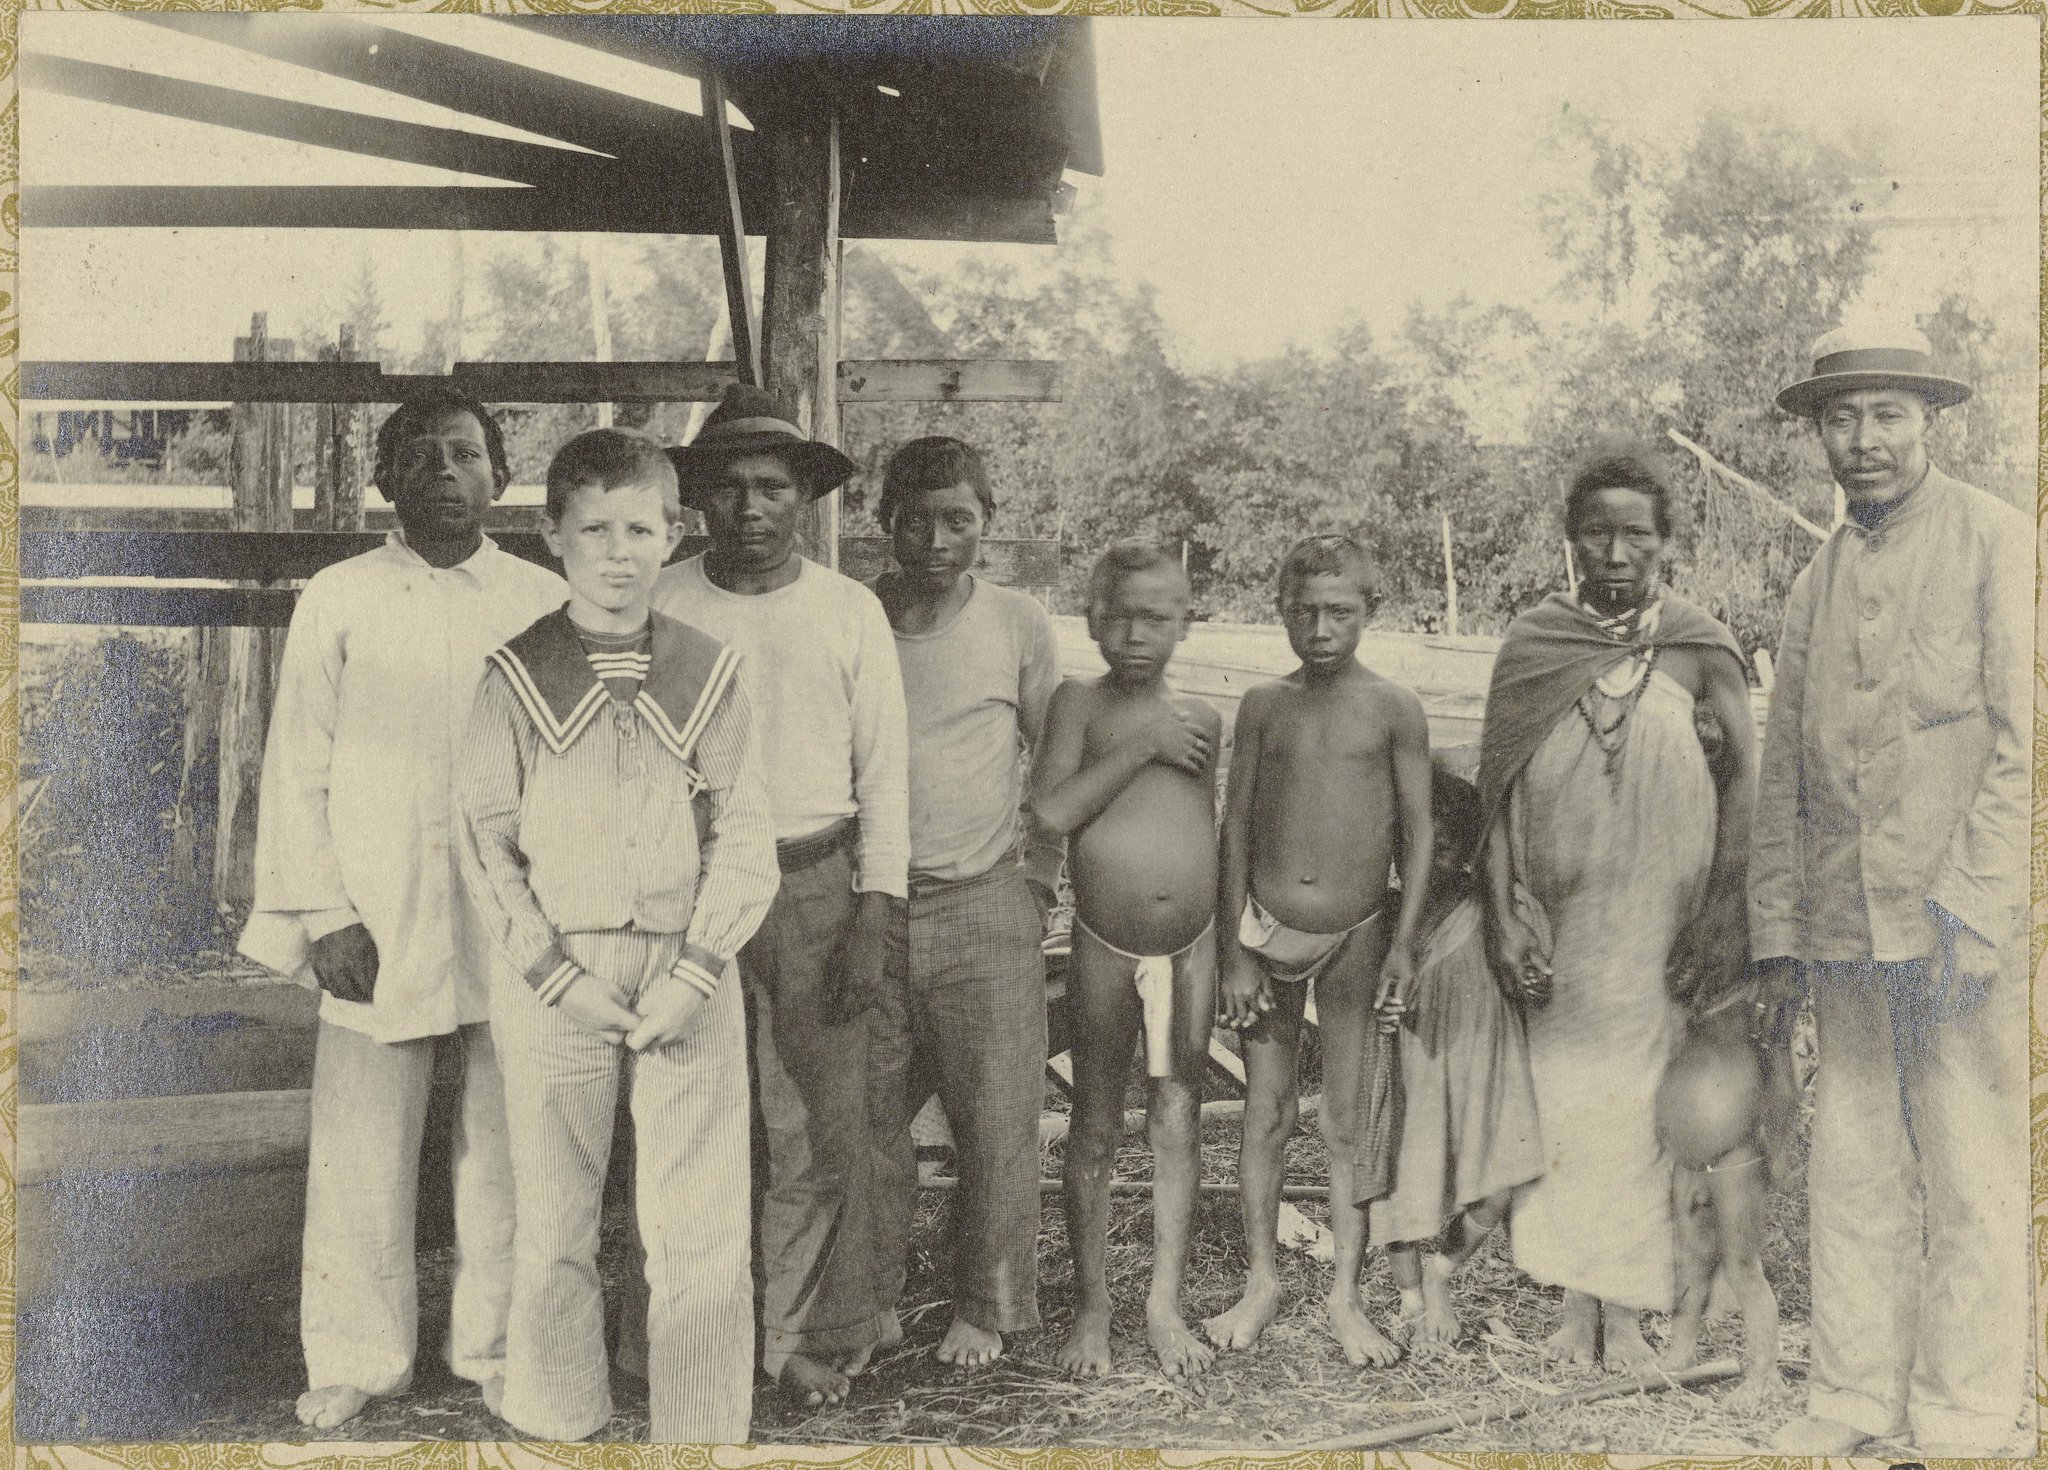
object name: photograph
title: Anton met Arowakken en Marrons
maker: hendrik doijer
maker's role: engineer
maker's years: 1863-1925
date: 1903-1910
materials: photographic support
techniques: gelatin silver print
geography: suriname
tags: suriname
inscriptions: inscription: ‘B2’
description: De Nederlandse jongen Anton staand poserend voor een groep Surinaamse Arowakken en Marrons. Onderdeel van het fotoalbum Souvenir de Voyage (deel 2), over het leven van de familie Doijer in en rond de plantage Ma Retraite in Suriname in de jaren 1903-1910.